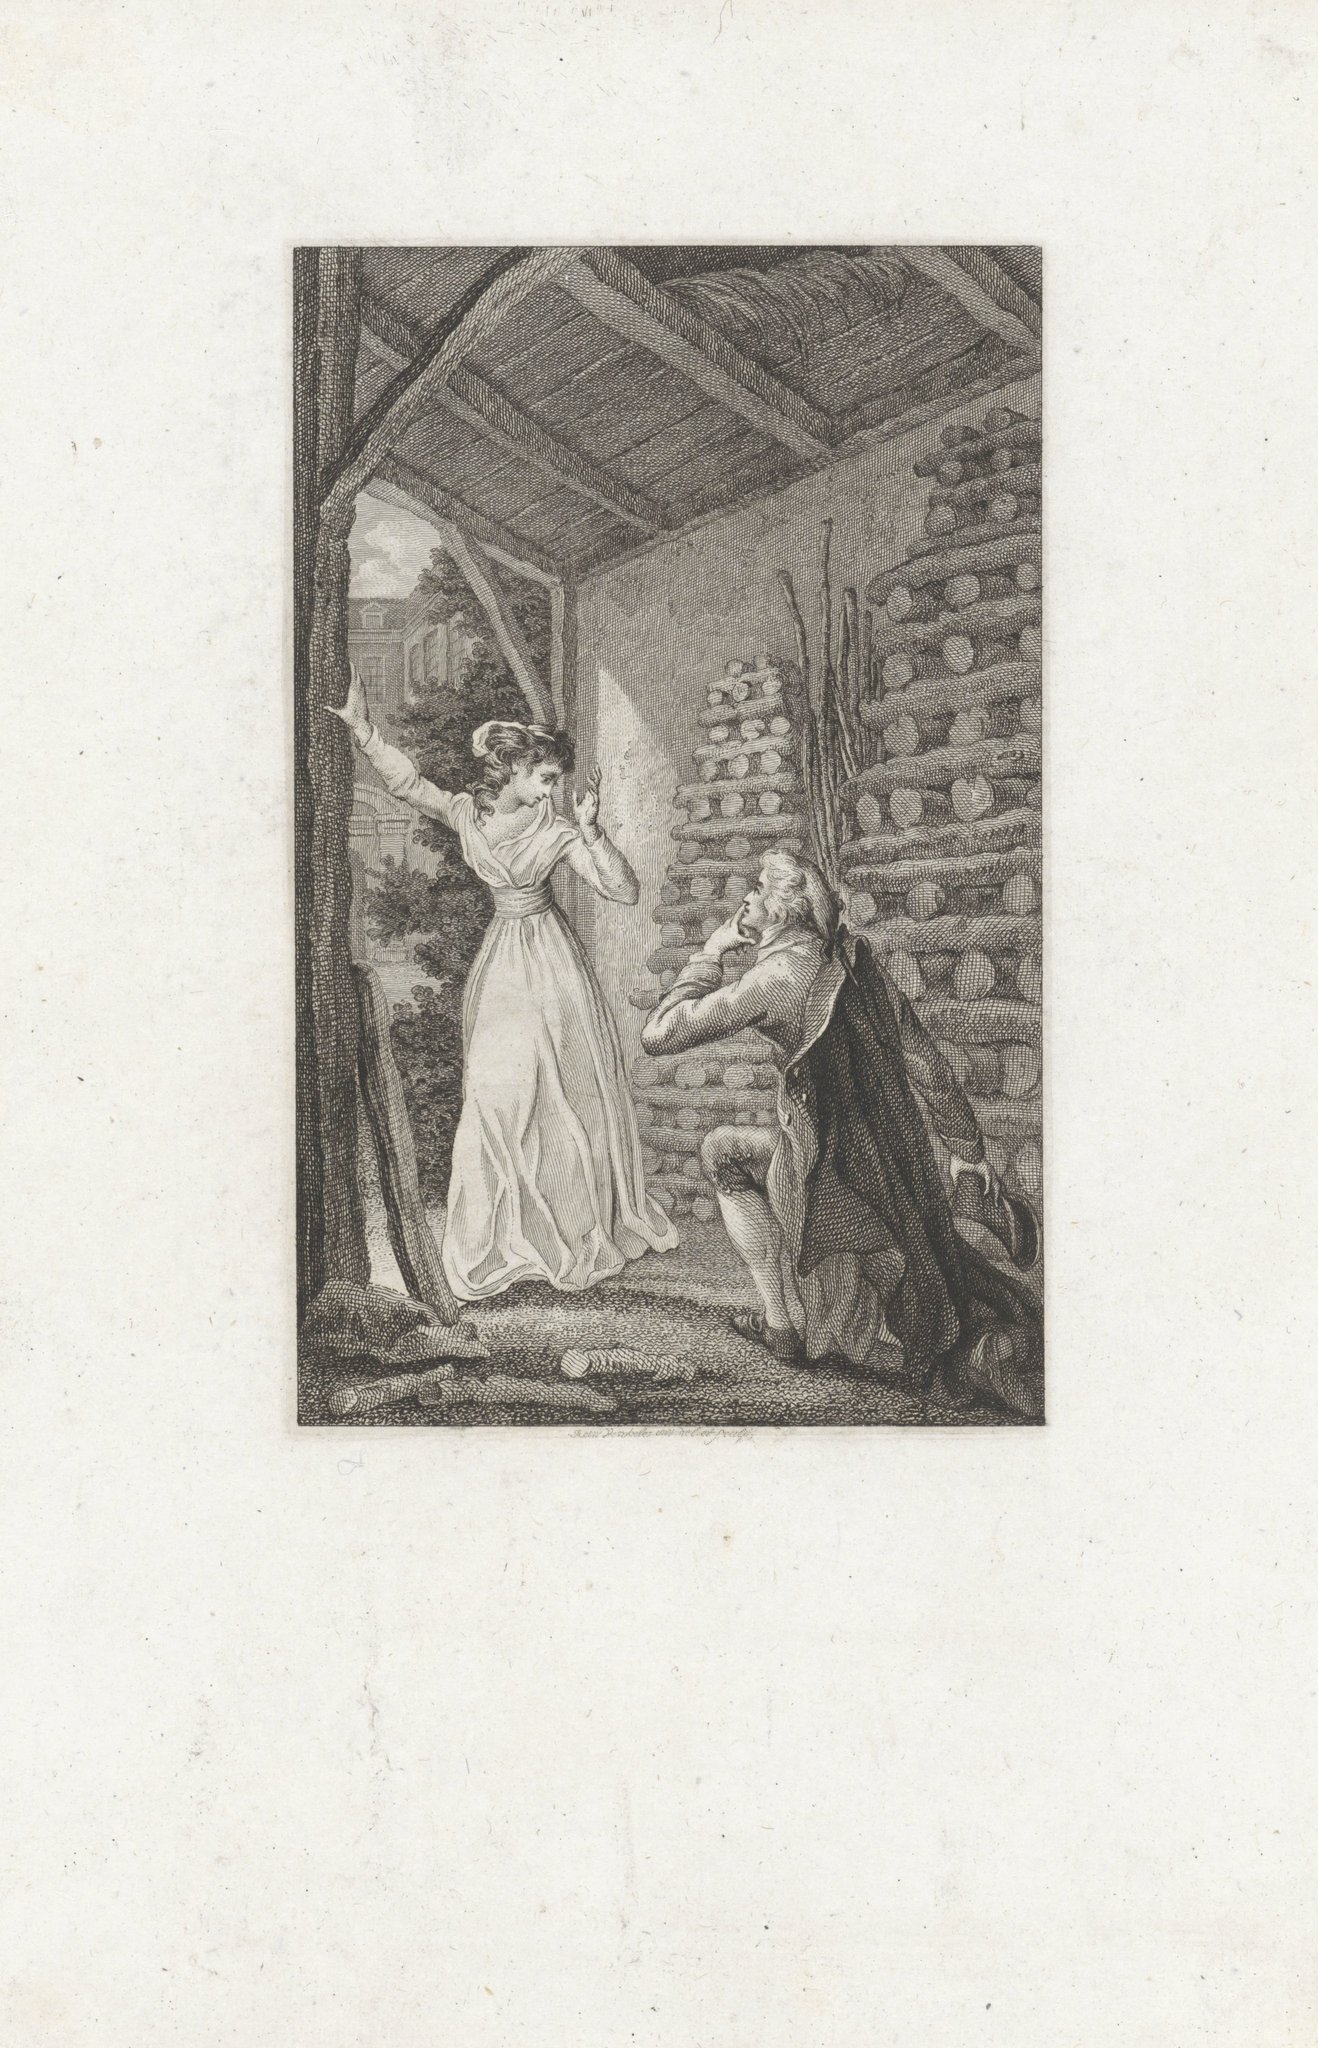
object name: print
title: Heer knielt voor een dame in een schuur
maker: reinier vinkeles (i)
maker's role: draughtsman, print maker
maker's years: 1741-1816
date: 1797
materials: paper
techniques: engraving, etching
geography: amsterdam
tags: beam, joist, rafter ~ building material, fainting, swooning, shed, kneeling figure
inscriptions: collector's mark: Lugt 240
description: Illustratie uit: Richardson, Samuel. Geschiedenis van Clarissa Harlowe. Deel 1. Amsterdam: Johannes Allart, 1797-1805.